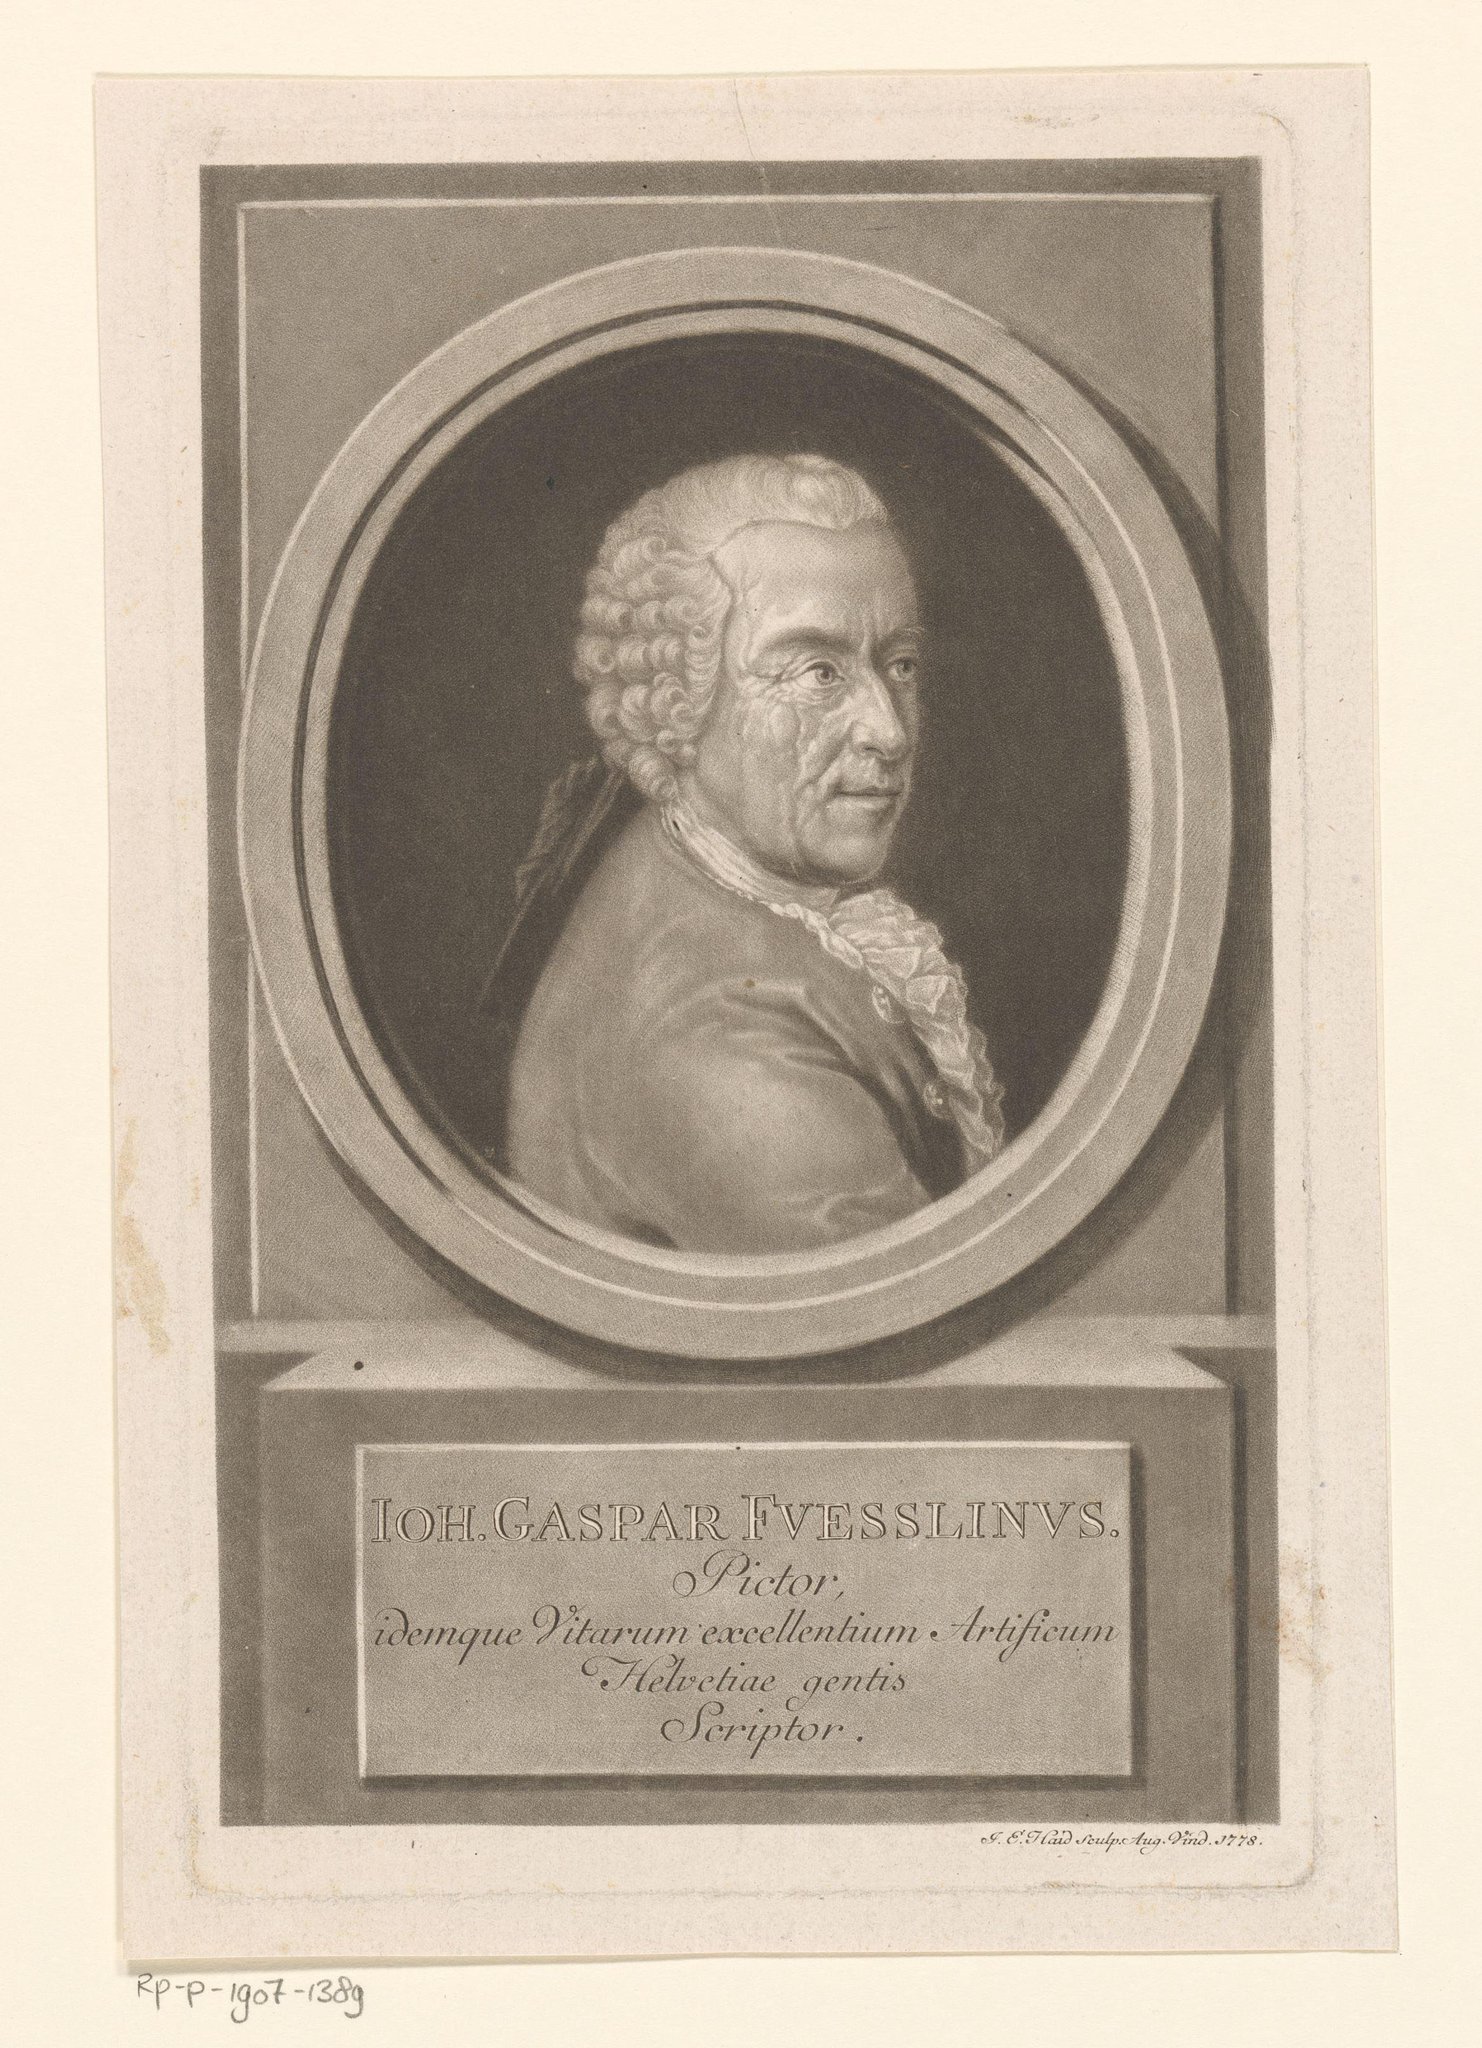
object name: print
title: Portret van Johann Caspar Füssli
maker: johann elias haid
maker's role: print maker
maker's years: 1739-1809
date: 1778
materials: paper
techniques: mezzotint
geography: augsburg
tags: johann caspar füssli, historical persons, portrait, self-portrait of painter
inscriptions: collector's mark: Lugt 2228